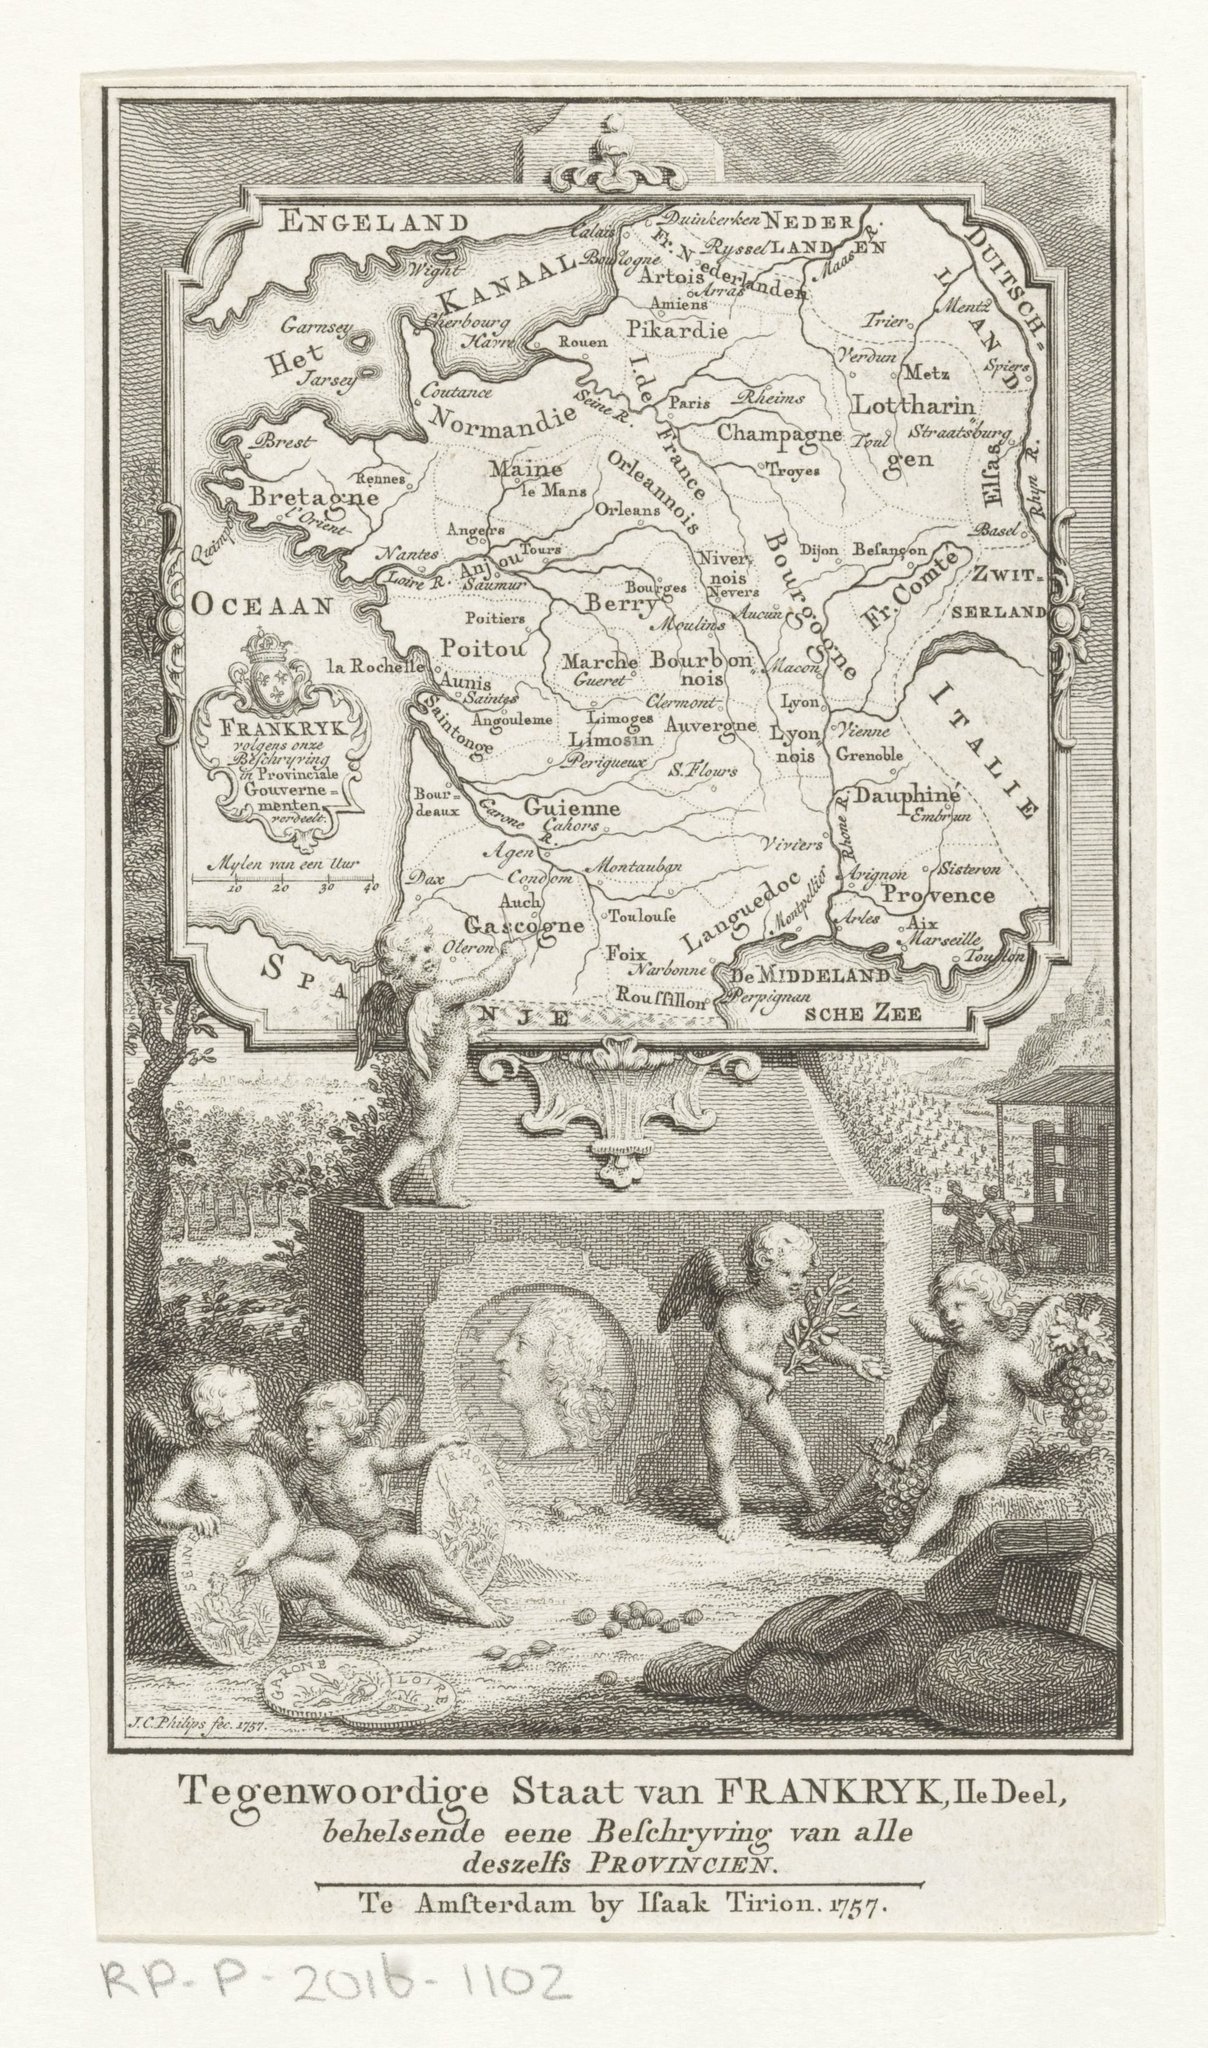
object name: titelblad, titelpagina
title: Titelpagina voor: Thomas Salmon, Hedendaagsche historie, of Tegenwoordige staat van Frankryk, 1757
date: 1757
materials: paper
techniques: engraving, etching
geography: amsterdam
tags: maps, atlases, cupids: 'amores', 'amoretti', 'putti', france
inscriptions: collector's mark: Lugt 2228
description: Titelpagina voor: Salmon, Thomas. Hedendaagsche historie, of Tegenwoordige staat van Frankryk. Amsterdam: Tirion, Isaak, 1757. Prent afkomstig uit een plakalbum met titelprenten, ornamenten etc. op blauw papier in 1983 uit elkaar gehaald. Volgens een notitie op verso zat de prent op p. 193 van dit album.